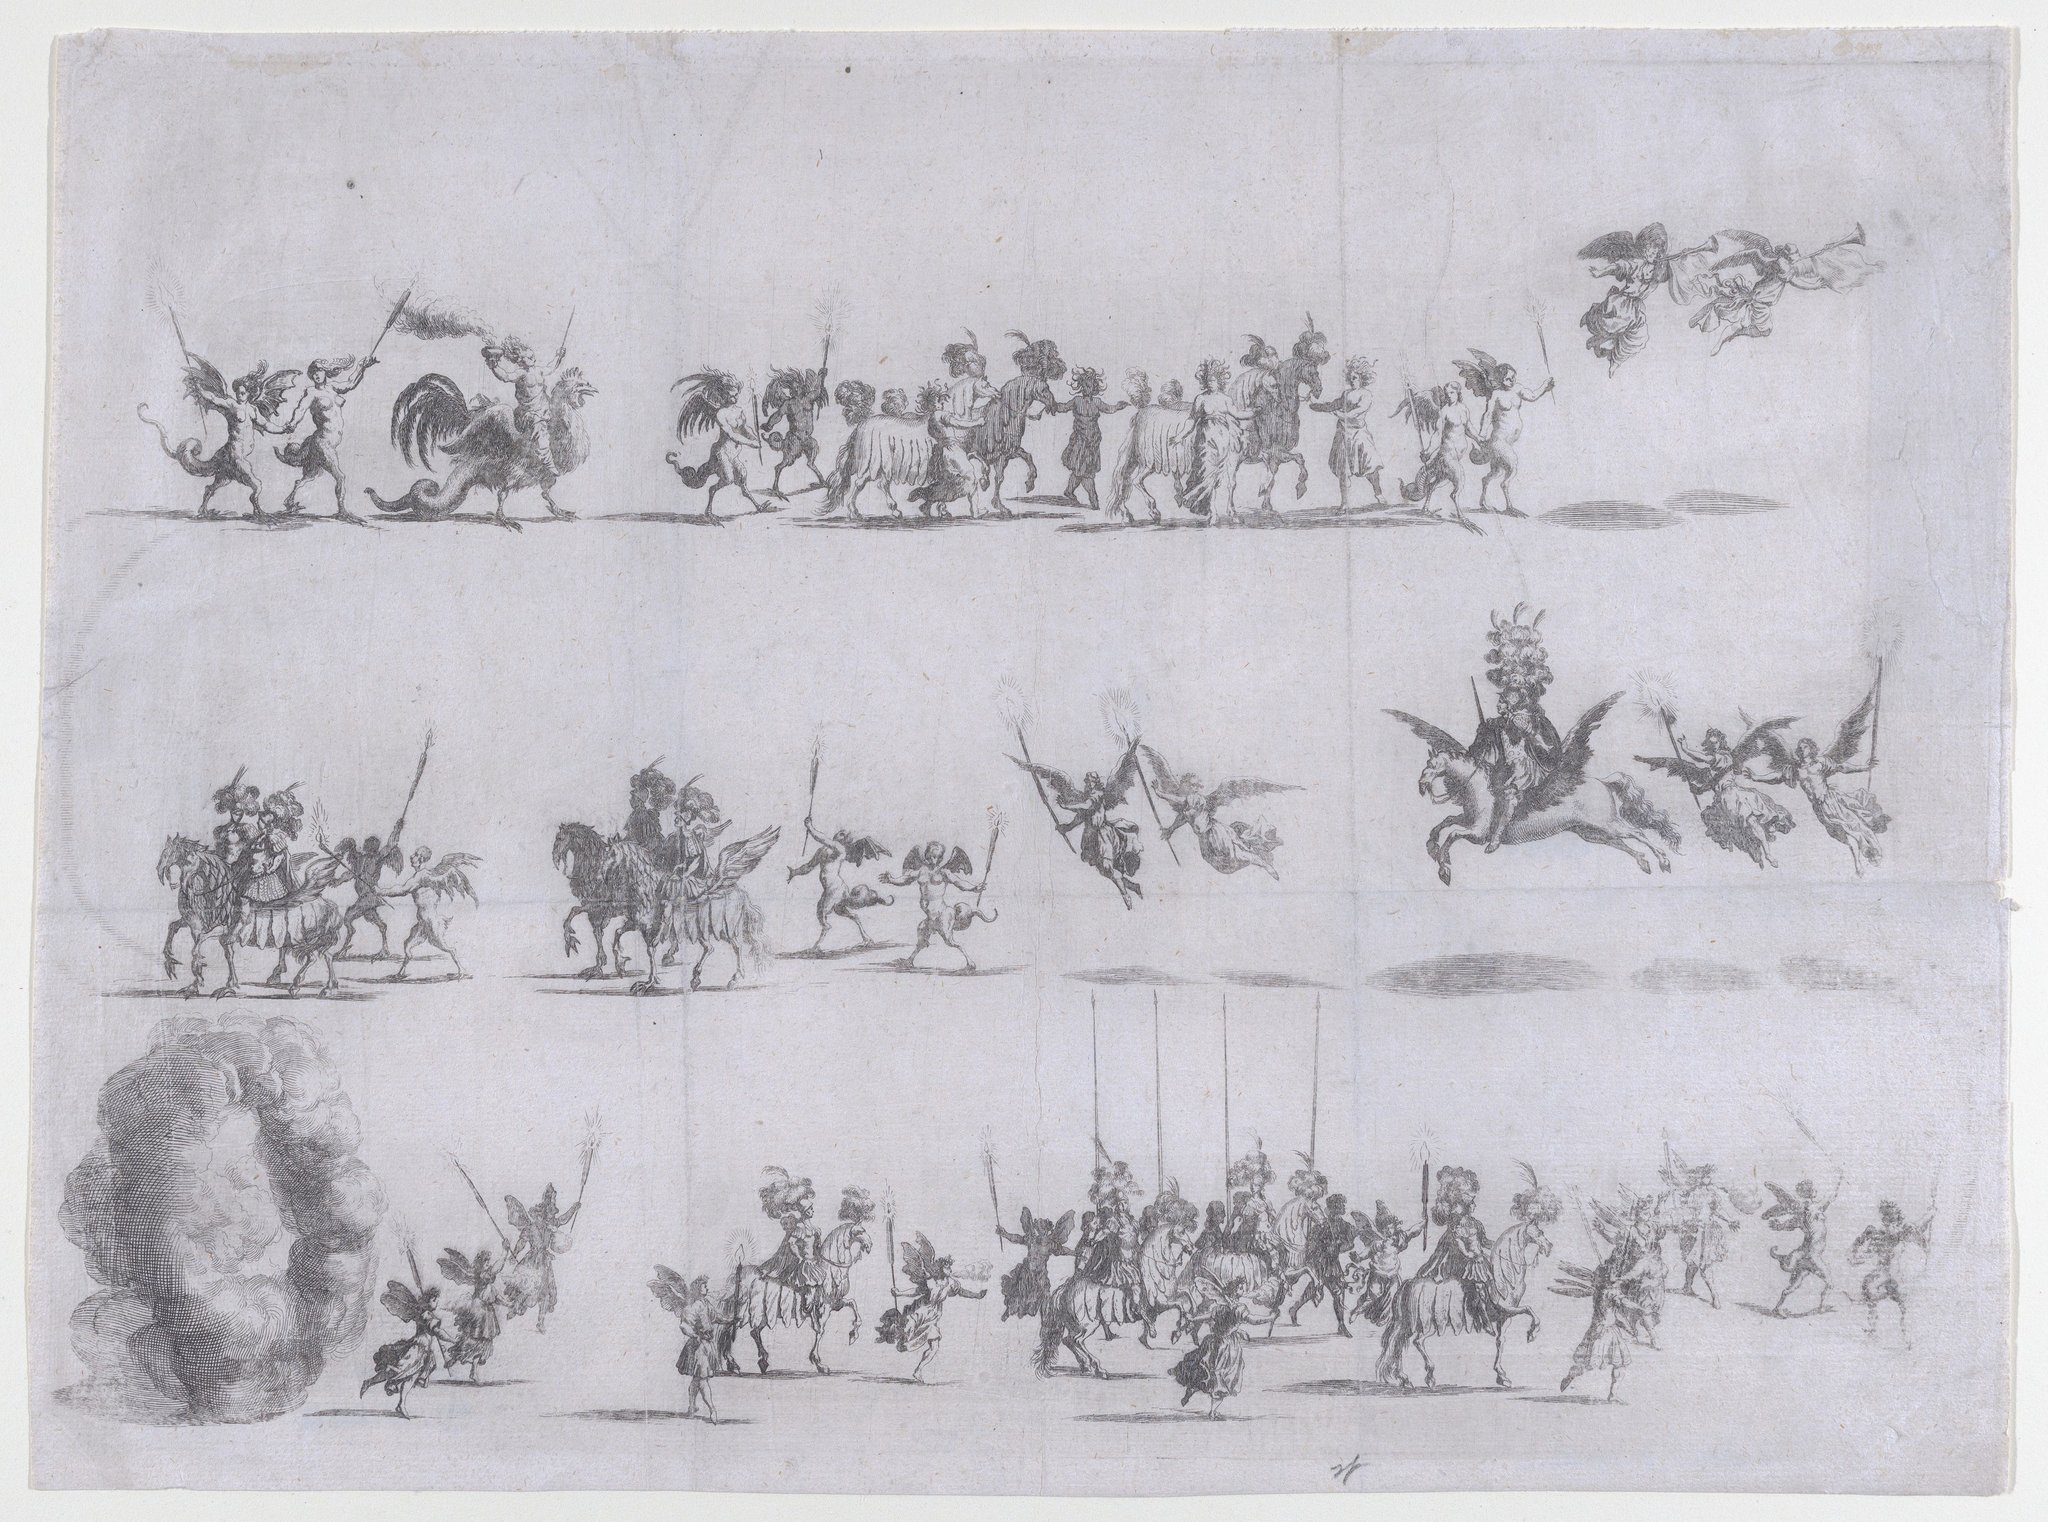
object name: print, fete, ornament architecture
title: Plate 10 from Pietro Paulo Bissari, Antiopa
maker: mathäus küsel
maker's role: artist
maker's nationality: german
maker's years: 1621-1682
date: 1662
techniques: etching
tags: horses